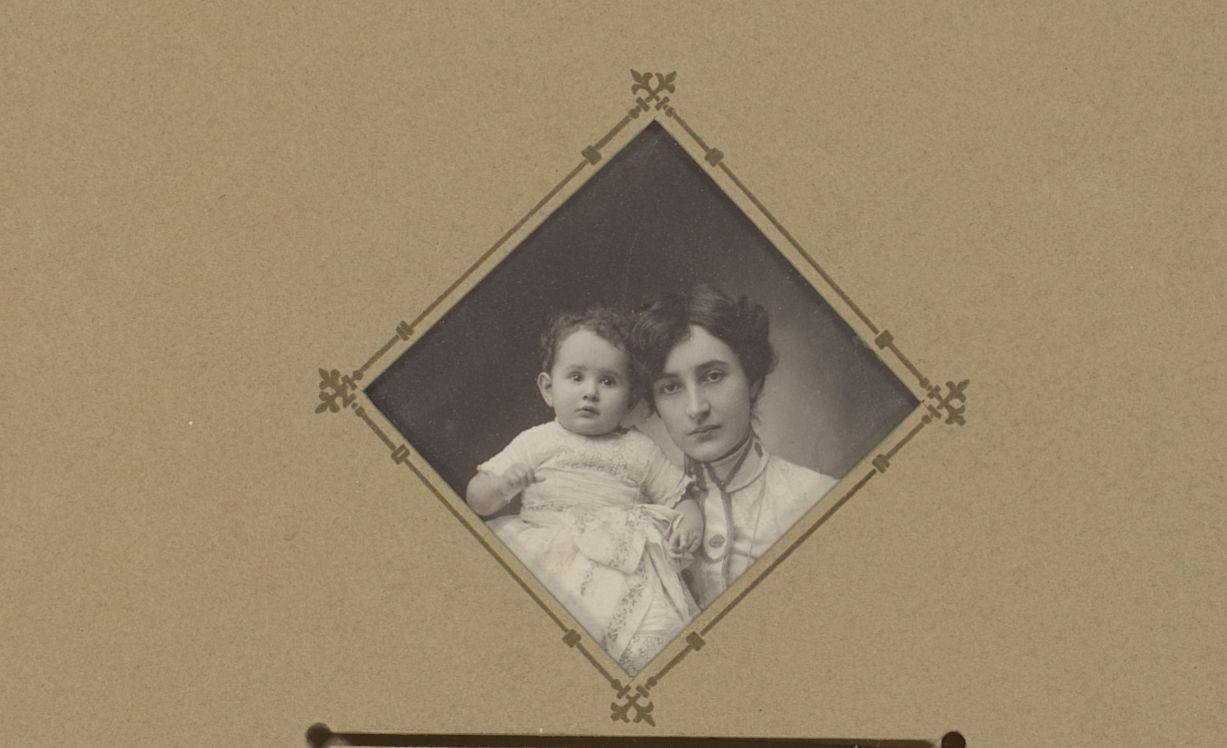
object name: album leaf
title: Portret van een vrouw en een kind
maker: Anonymous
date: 1895-1920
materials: cardboard, photographic support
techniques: matte daylight collodion silver print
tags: historical persons - bb - woman, toddler (female)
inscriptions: number: ‘6’